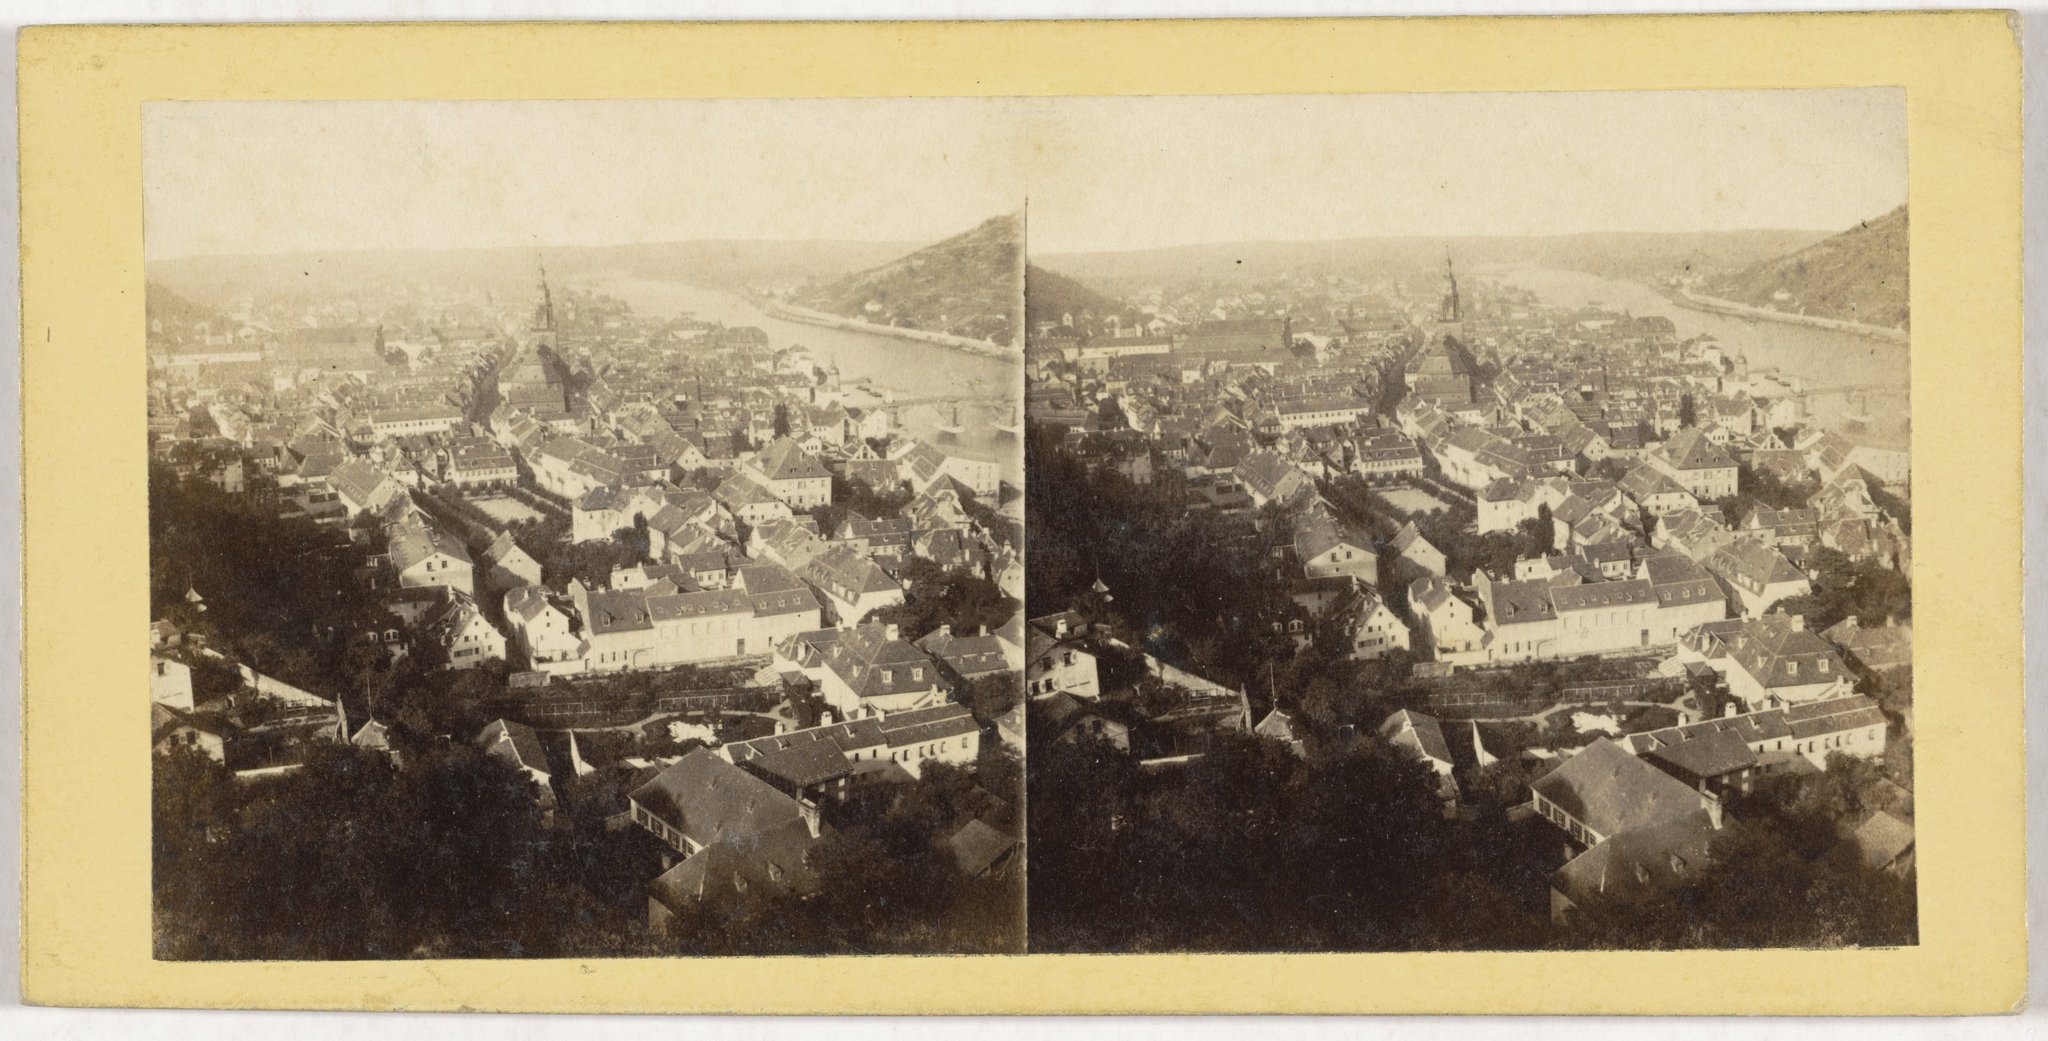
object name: stereograph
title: Gezicht op Heidelberg, Duitsland, gezien vanuit Schloss Heidelberg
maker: Anonymous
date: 1861-1870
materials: cardboard, paper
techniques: albumen print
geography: heidelberg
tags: city-view in general; 'veduta'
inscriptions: number: ‘No 56’